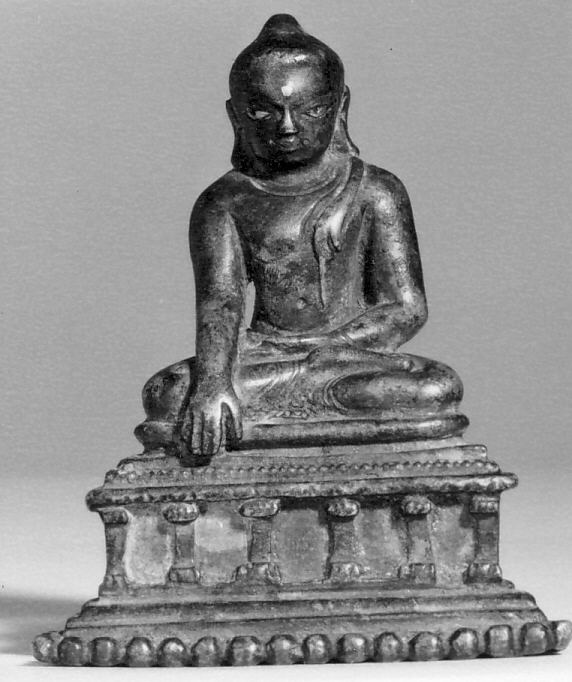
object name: figurine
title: Seated Buddha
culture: indian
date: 1001-1100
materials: bronze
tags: buddhism,buddha